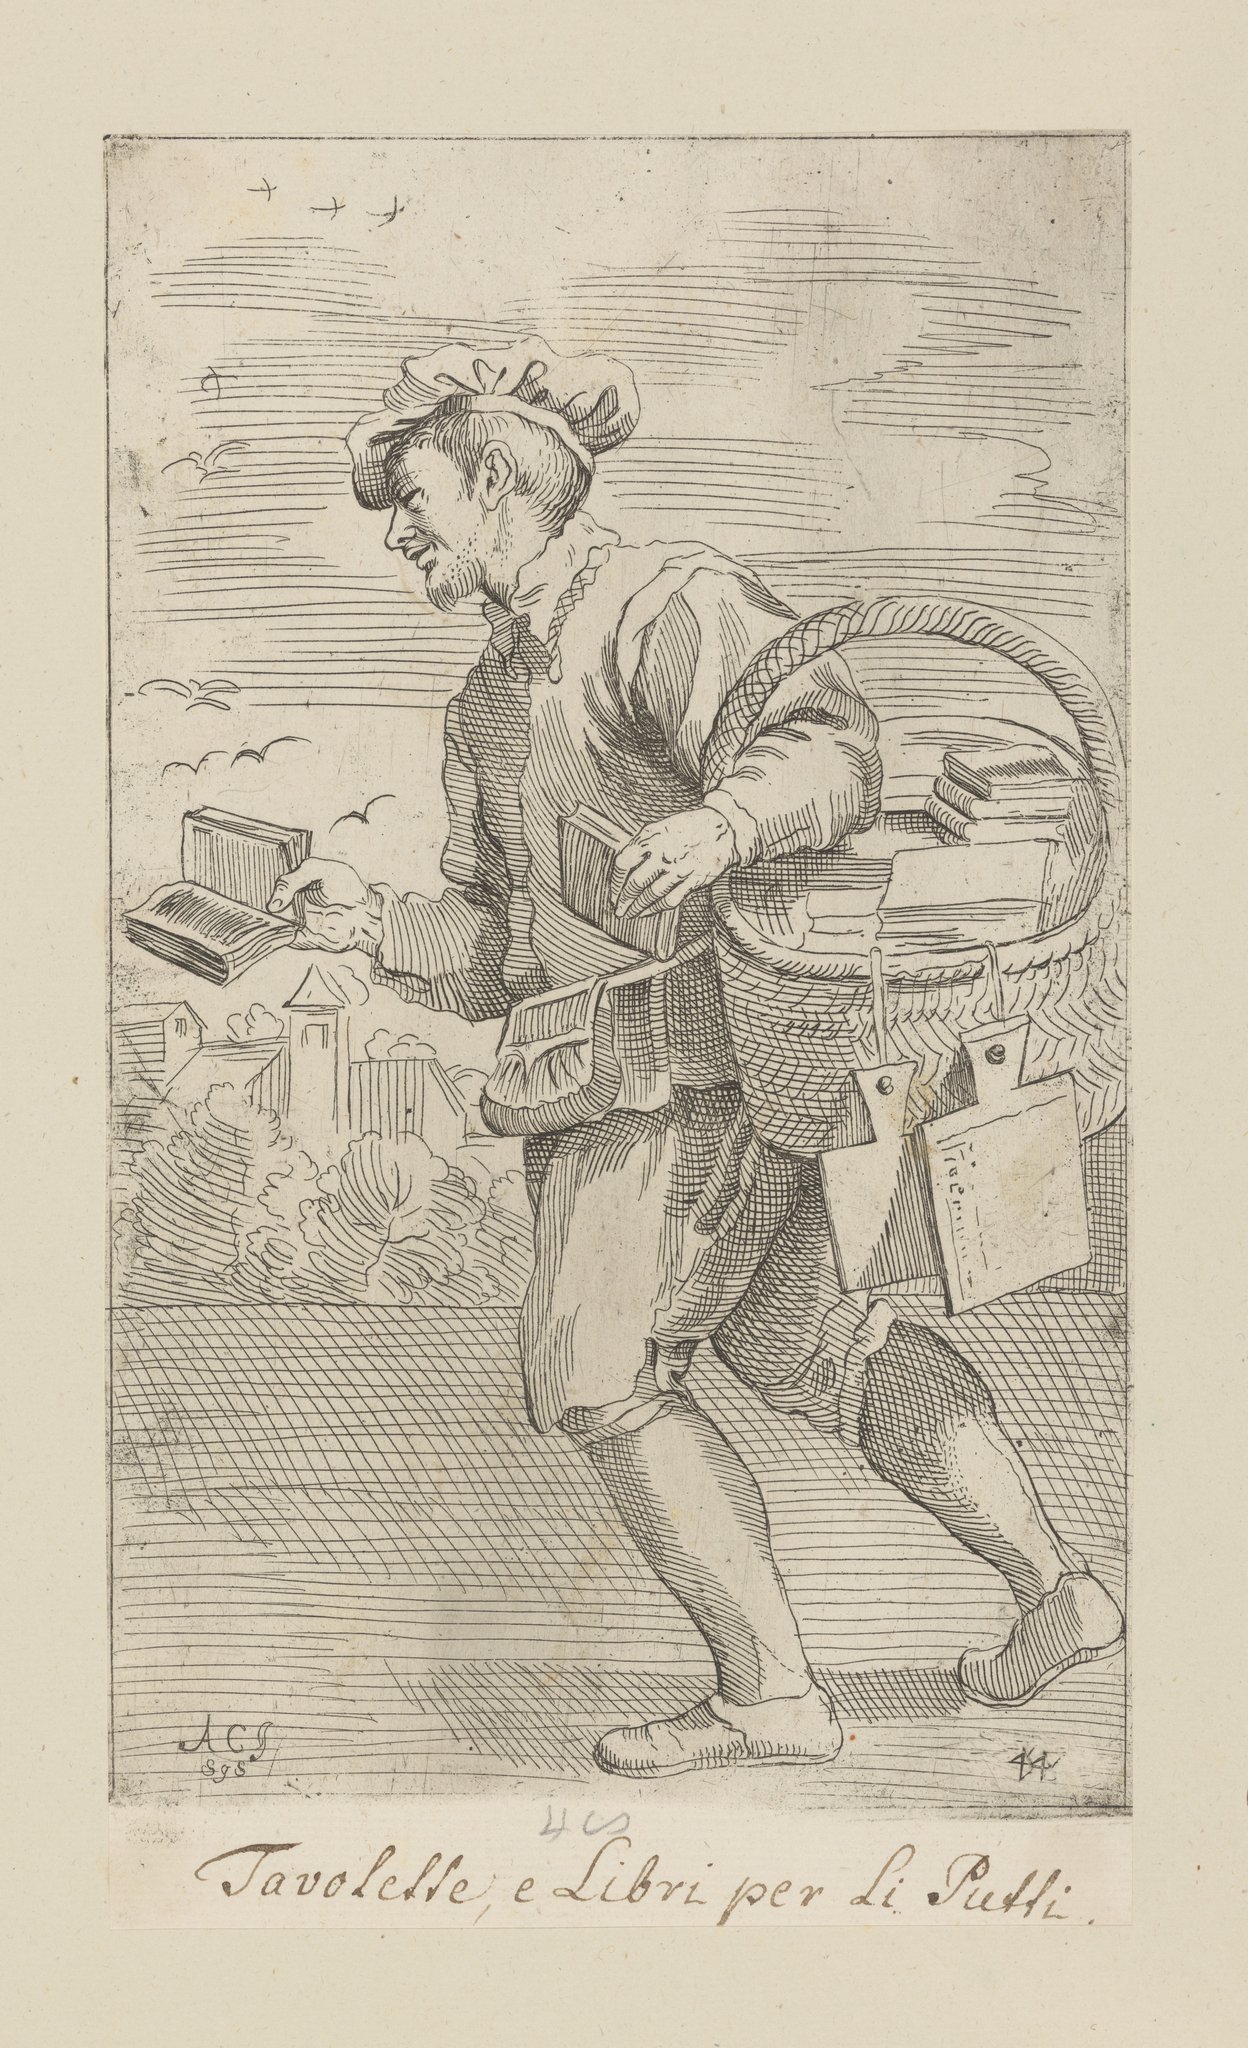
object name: print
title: Plate 44: Vendor of book and tablets for children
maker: simon guillain ii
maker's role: artist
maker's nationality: french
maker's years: 1618-1718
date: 1646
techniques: etching